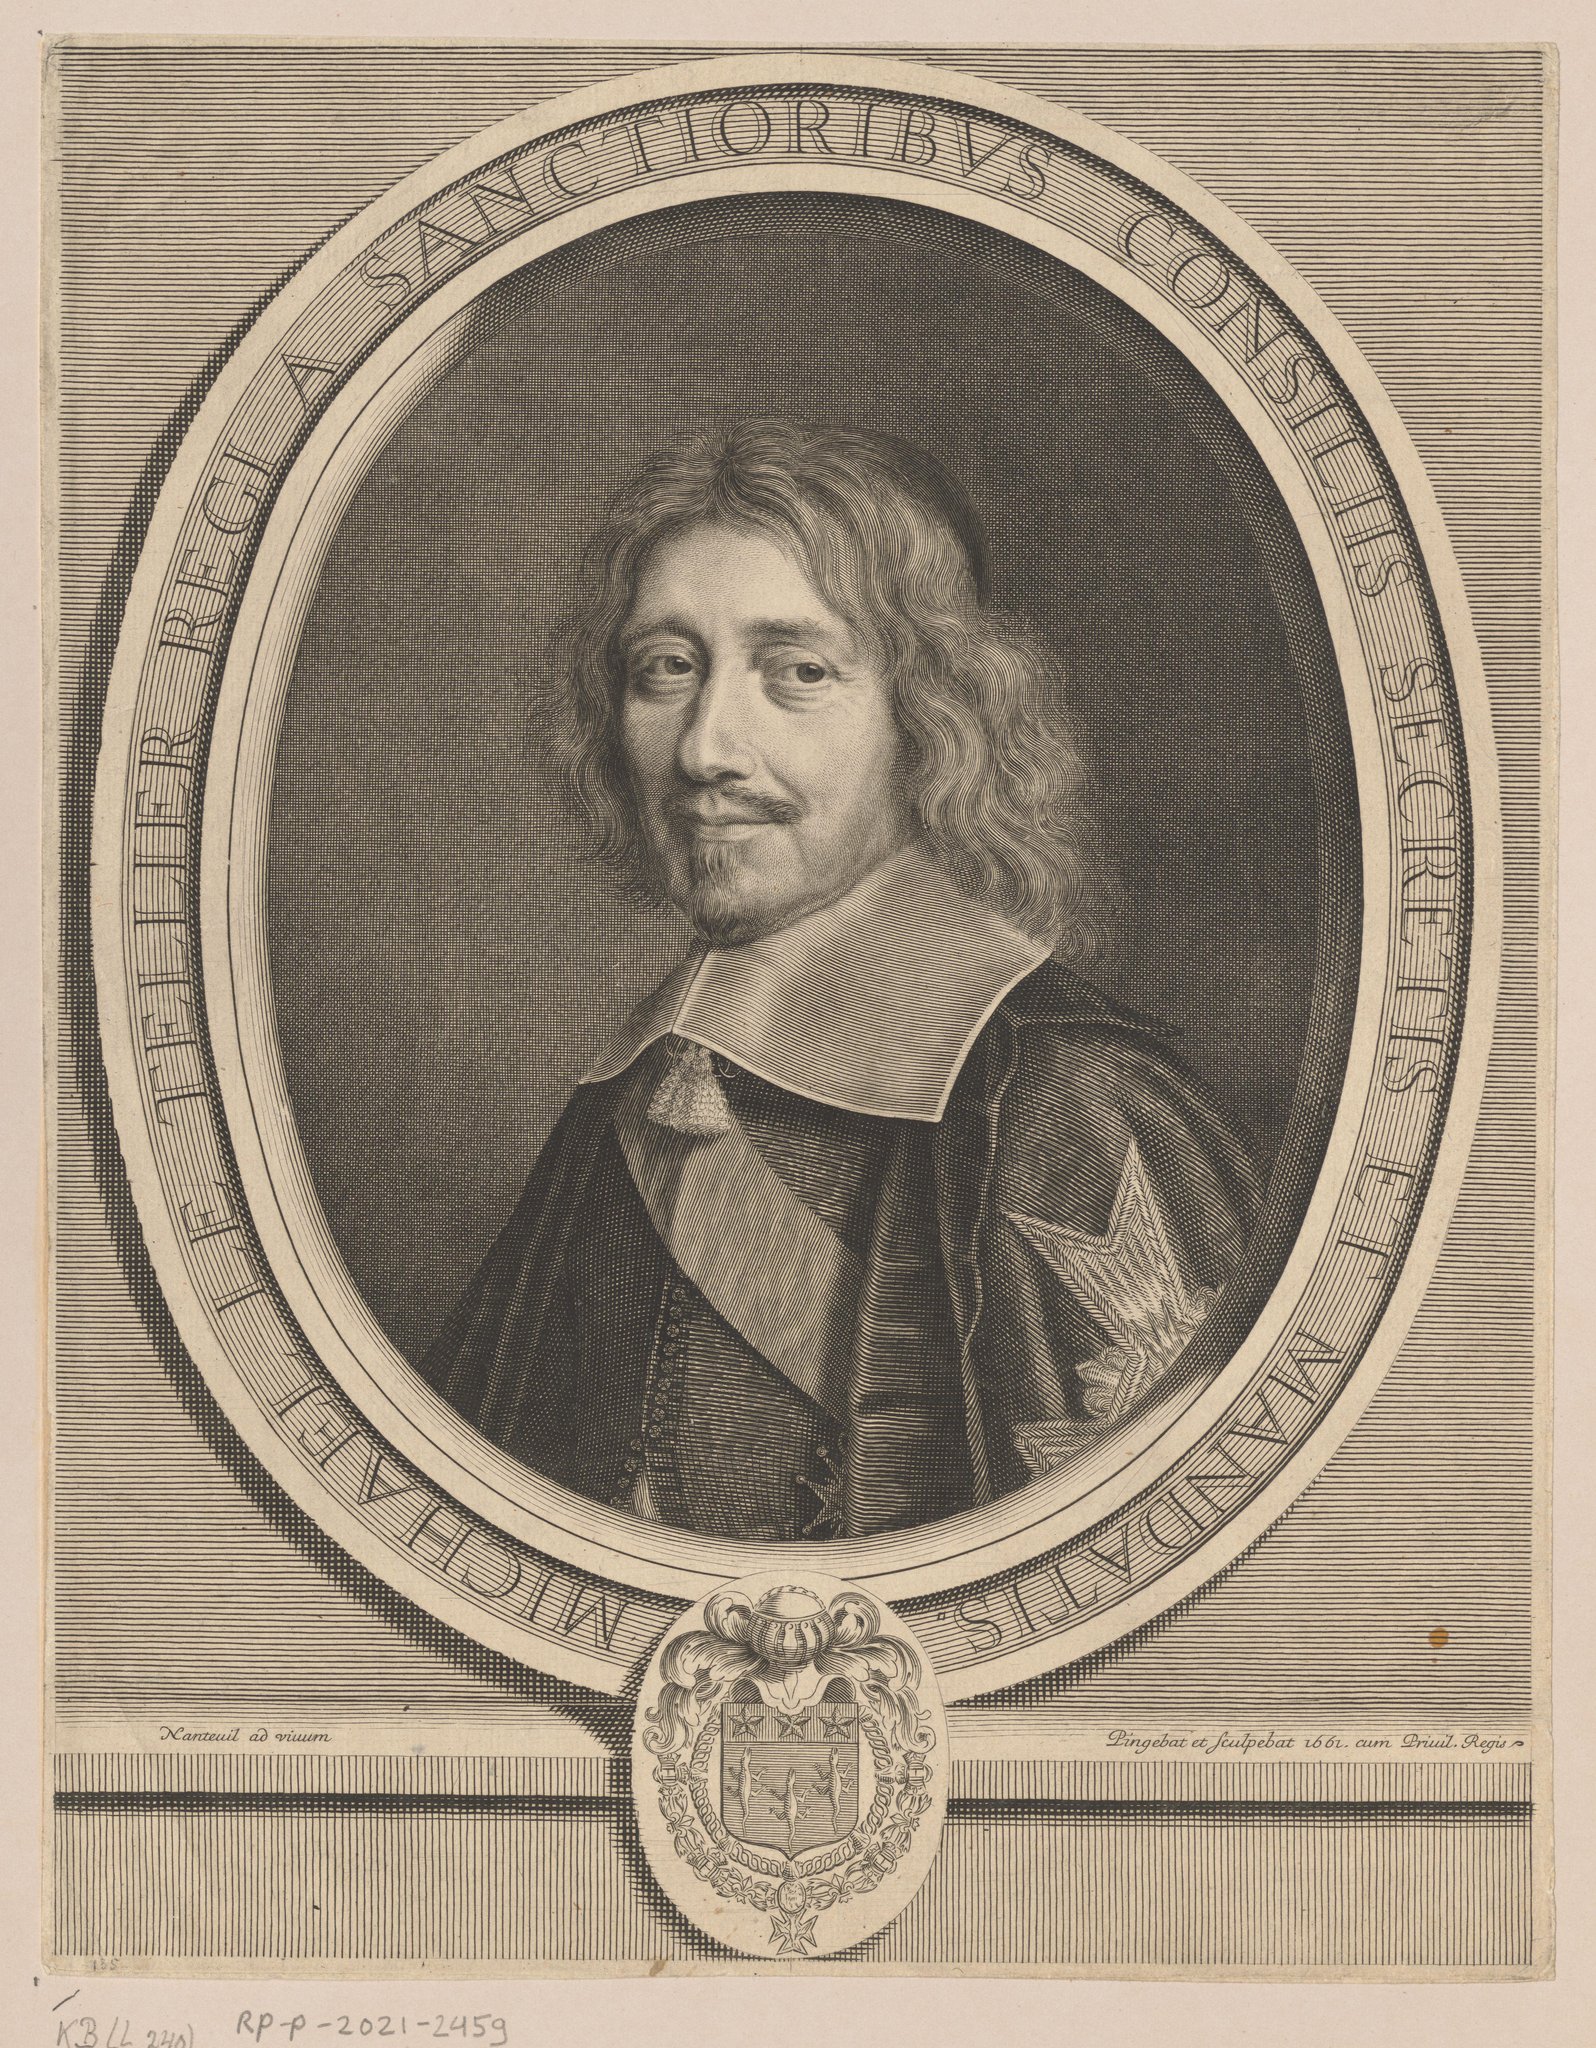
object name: print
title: Portret van Michel Le Tellier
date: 1661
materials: paper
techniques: engraving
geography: france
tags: paris, michel le tellier, official; civil servant; functionary (in general), ornament ~ medallion, historical persons, armorial bearing, heraldry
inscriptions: collector's mark: Lugt 240